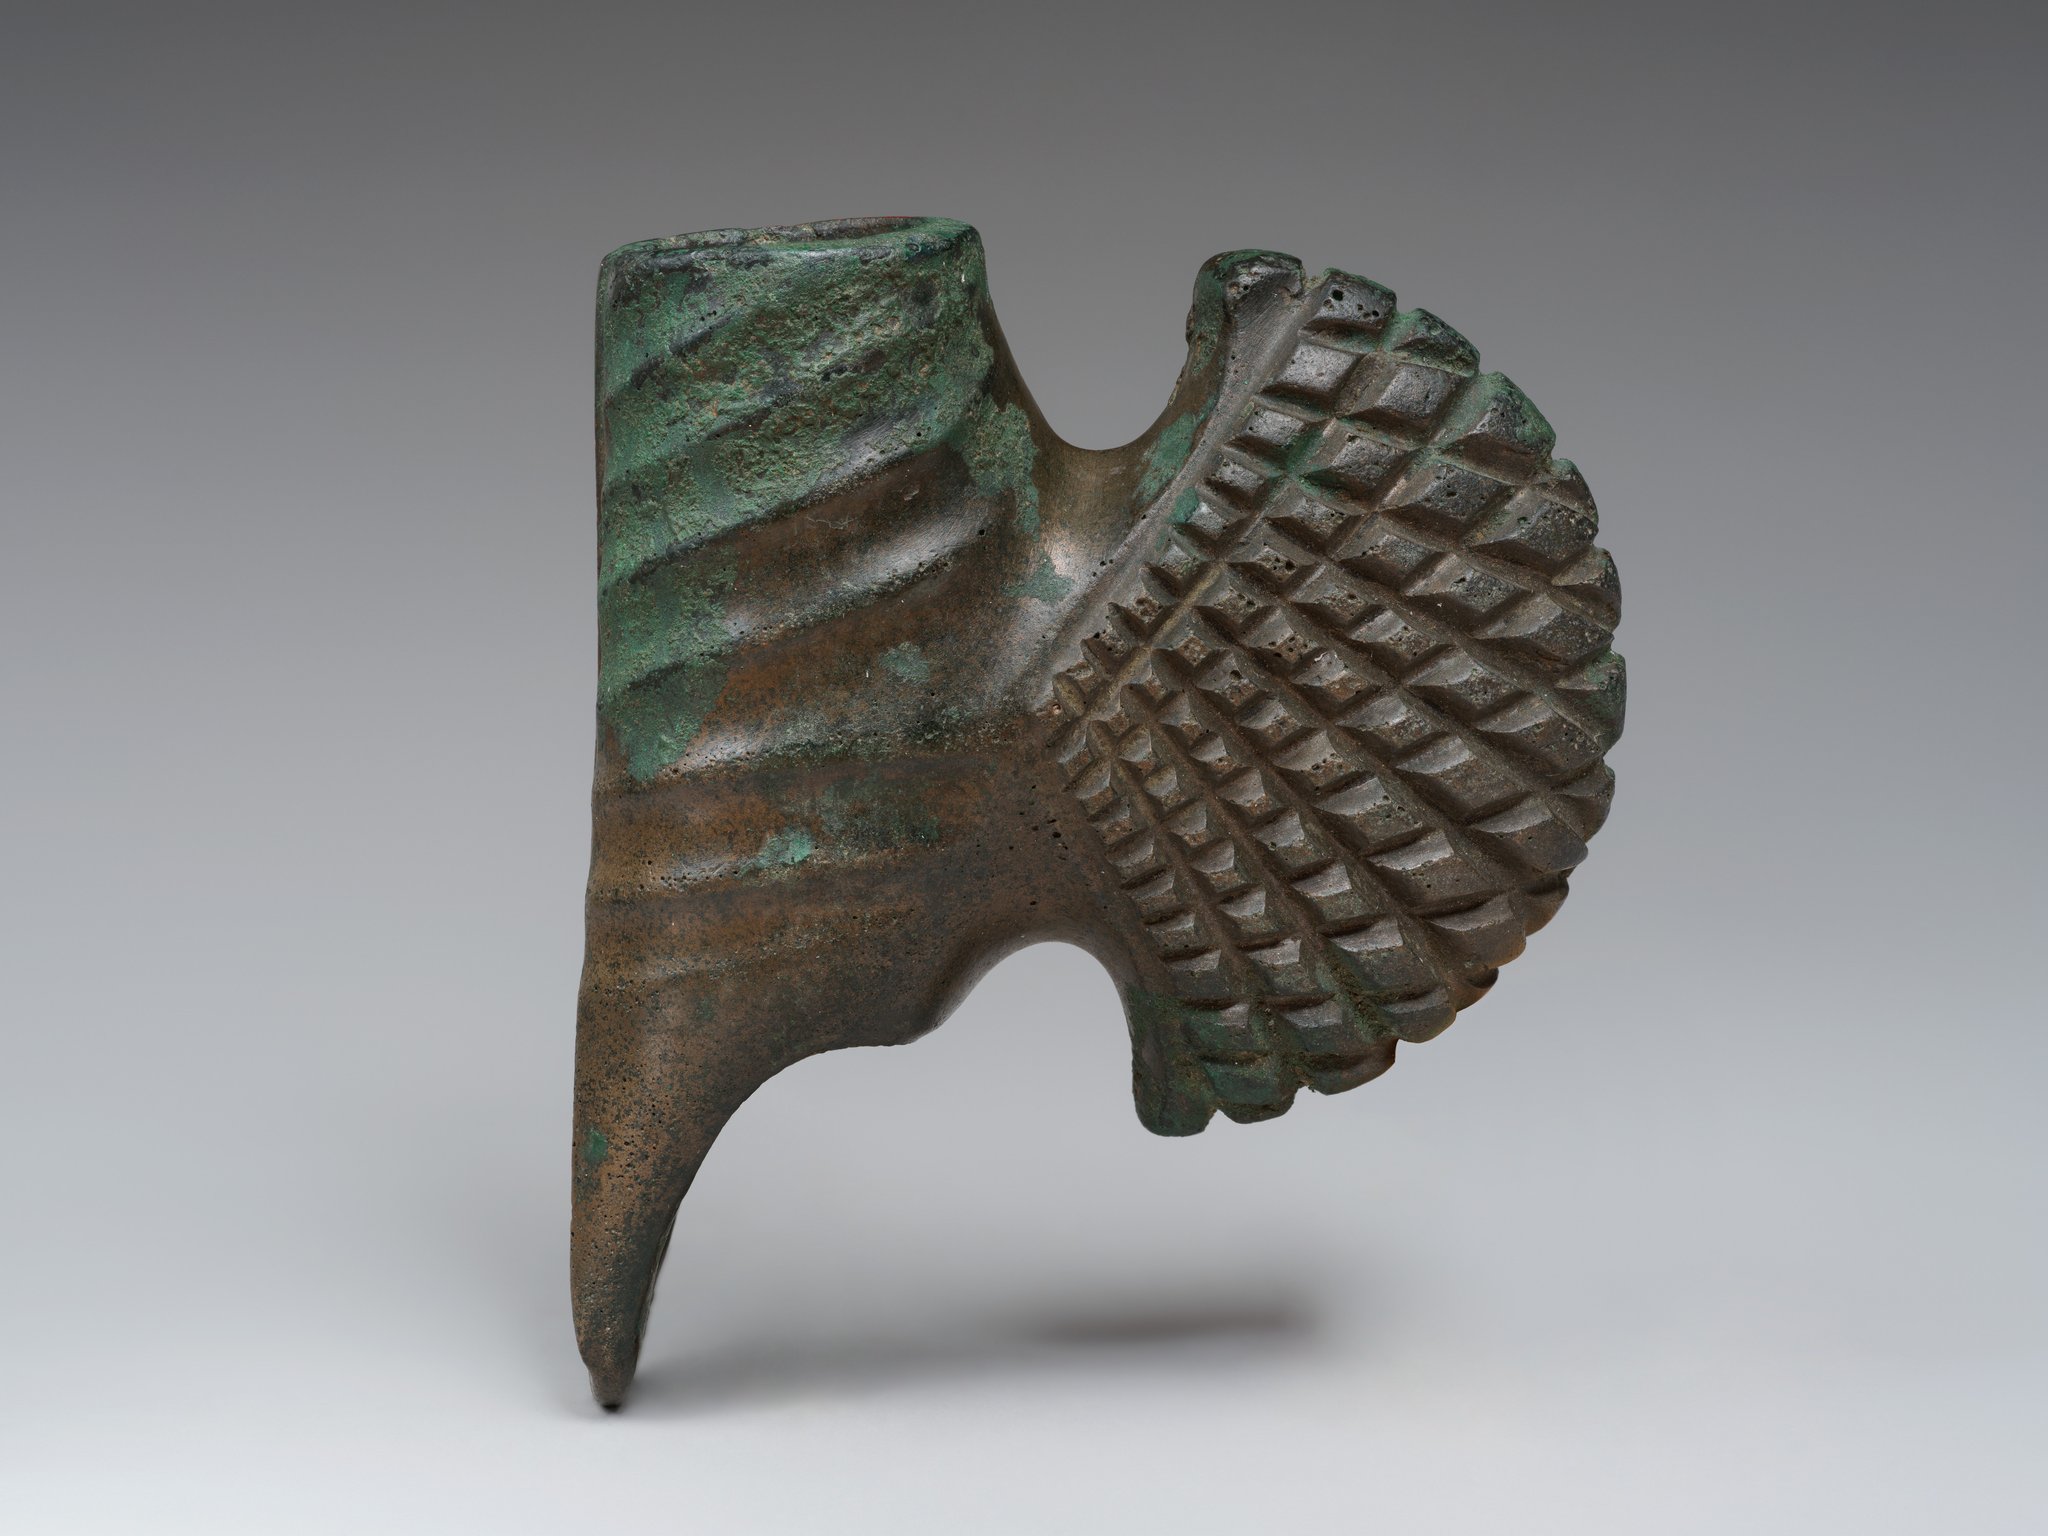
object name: axe or mace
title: Axe or mace head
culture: hattian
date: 2300-2000 BCE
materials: bronze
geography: central anatolia